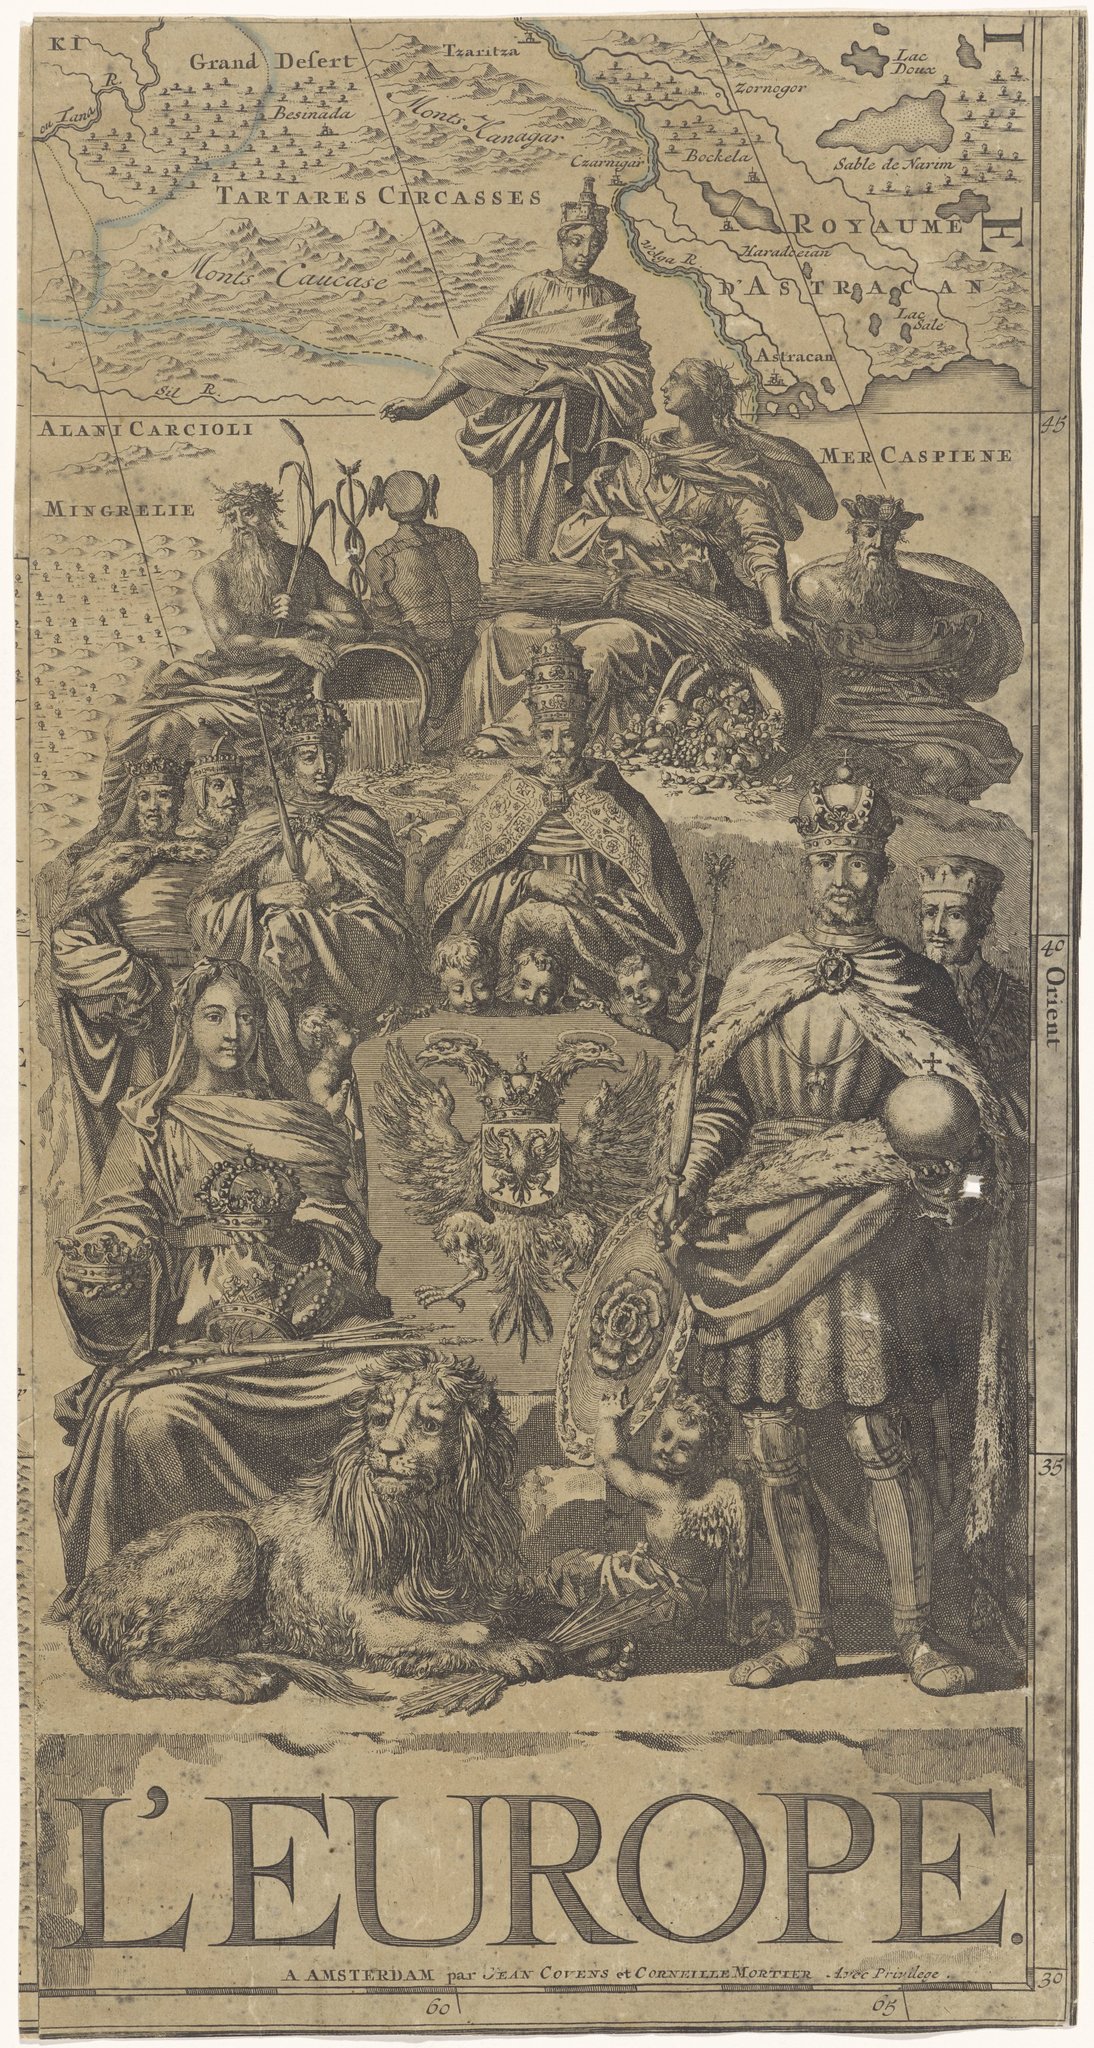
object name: print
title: Vignet voor een kaart van Europa met machthebbers en personificaties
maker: Anonymous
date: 1720-1772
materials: paper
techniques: etching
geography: amsterdam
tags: city-crown, mural crown, (story of) ceres (demeter), maps of separate countries or regions, knighthood order of the golden fleece, ruler, sovereign, pope, mercury (planet), insignia and symbols of sovereignty (crown, diadem, sceptre, orb, seal, standard, cloak, pectoral)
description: Vignet voor een kaart van Europa, met enkele kinderen die het keizerlijk wapenschild vasthouden. Rondom het wapen diverse hoogwaardigheidsbekleders zoals de paus, een doge, een hertog, een koning en een keizer met de rijksappel. Voor het wapenschild ligt een leeuw met een pijlenbundel onder zijn poot. Achter de leeuw een vrouw die diverse kronen en scepters op haar schoot heeft. Op de achtergrond voert een vrouw, met een stedenkroon, een gesprek met Ceres terwijl Mercusius hen de rug toe keert. Het drietal wordt geflankeerd door een riviergod en een zeegod.